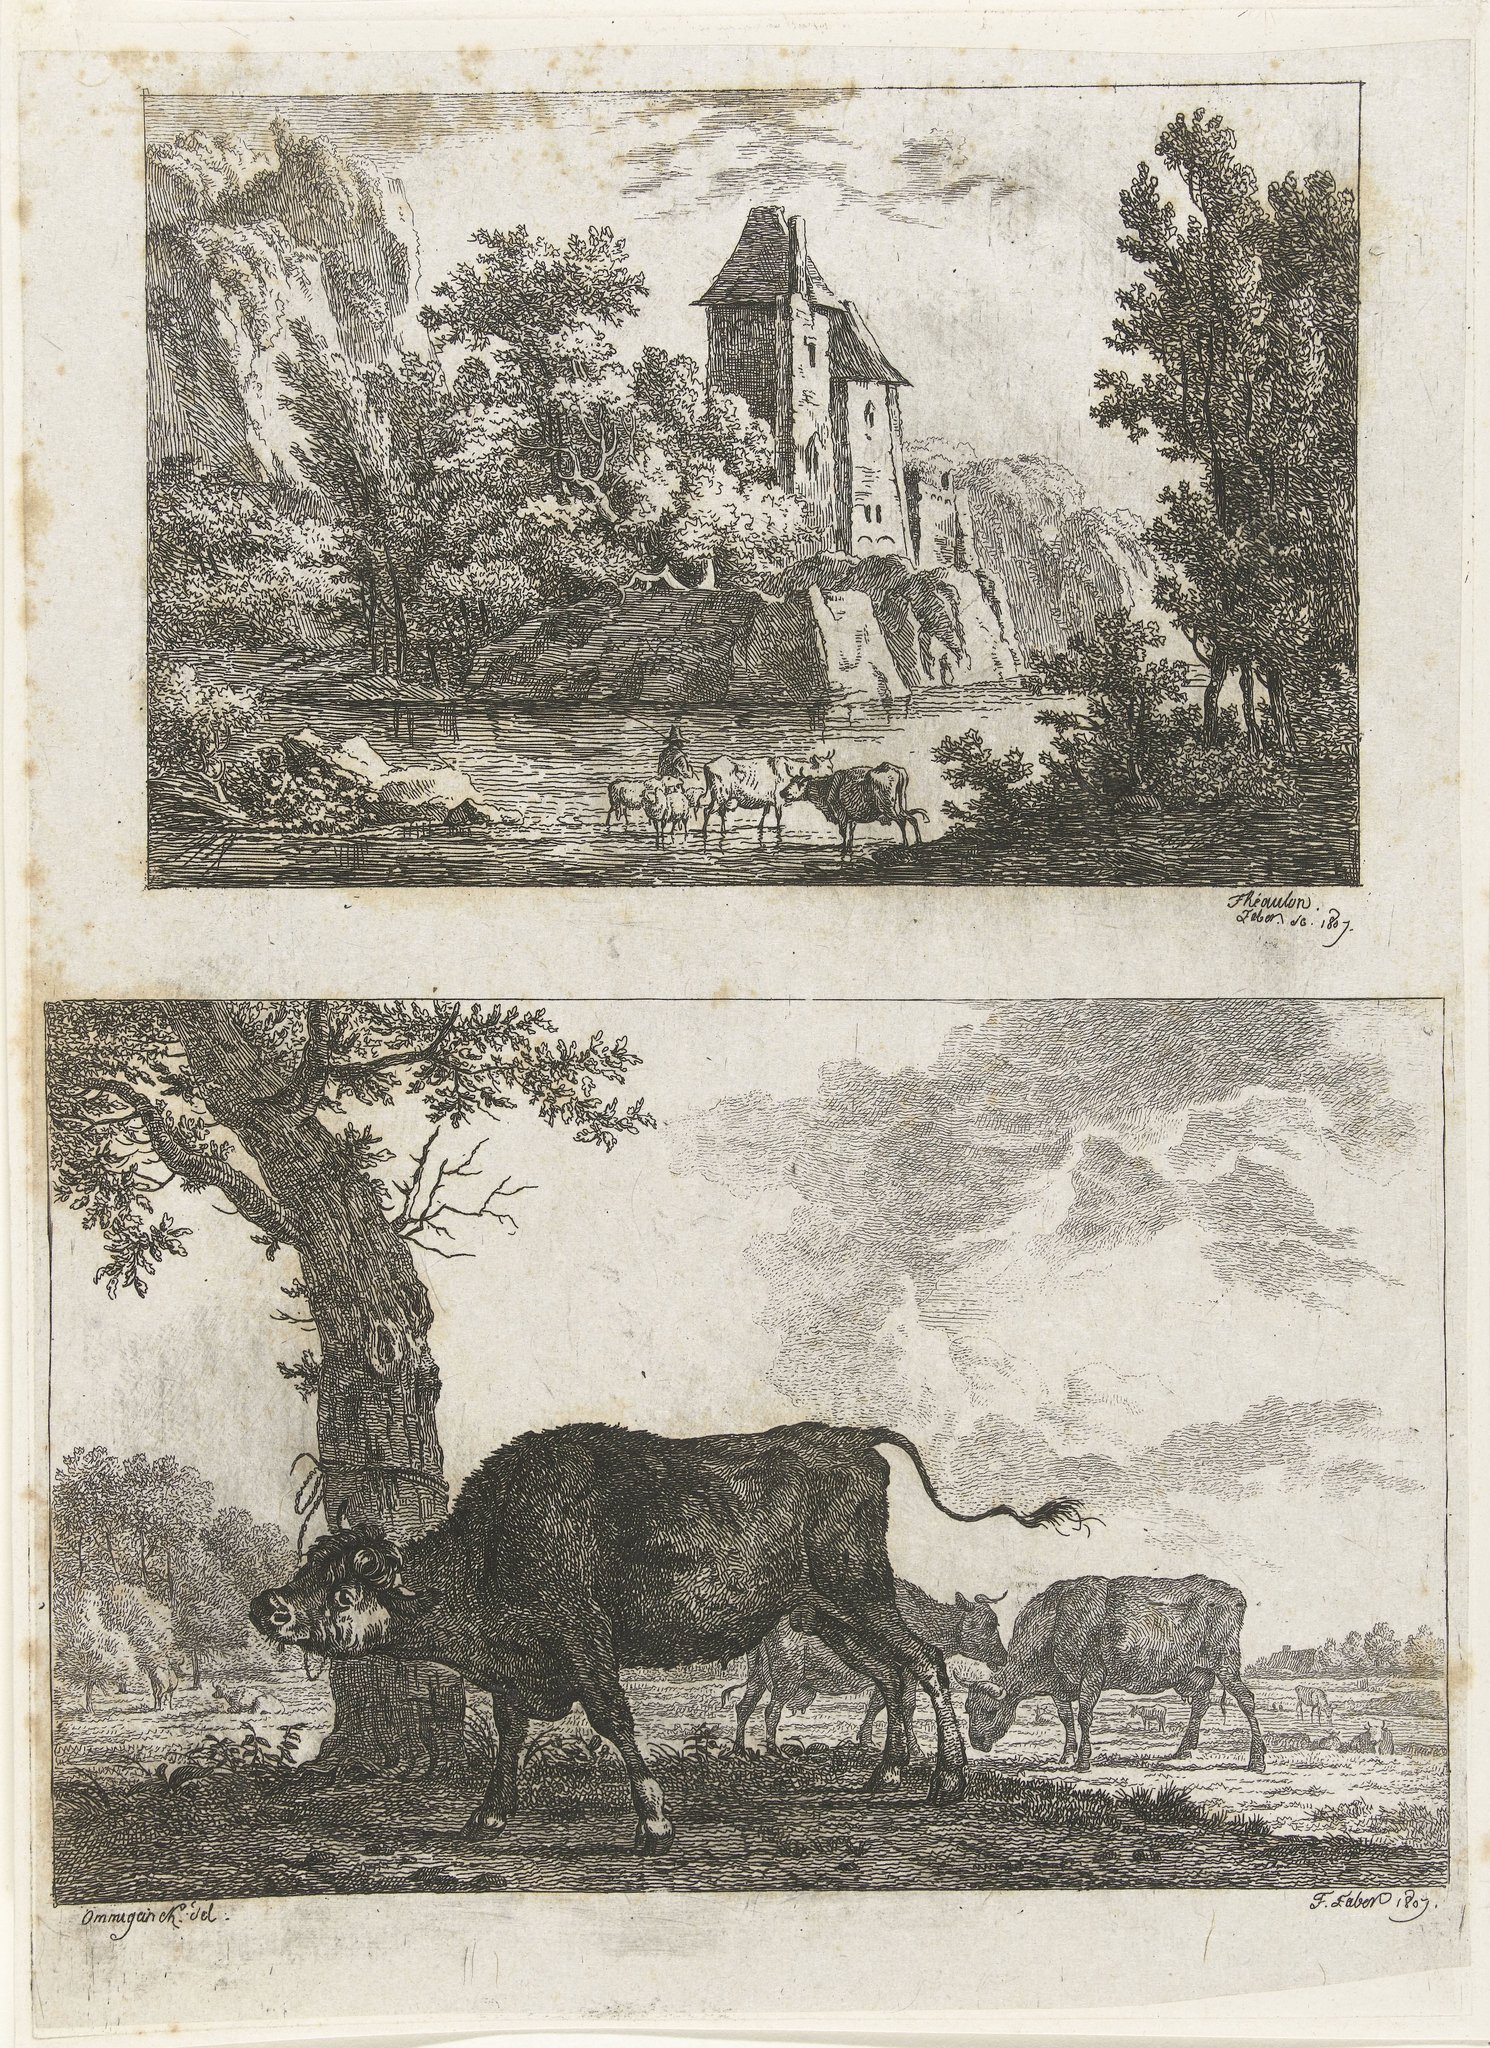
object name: print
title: Landschap en stier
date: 1807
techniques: printmaking, etching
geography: brussels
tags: cattle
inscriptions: collector's mark: Lugt 2228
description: Twee landschappen op één blad. Boven: een berglandschap met een gezicht op een kasteel en op de voorgrond een herder met zijn kudde in ondiep water. Onder: een stier, met een touw vastgezet aan een boom.